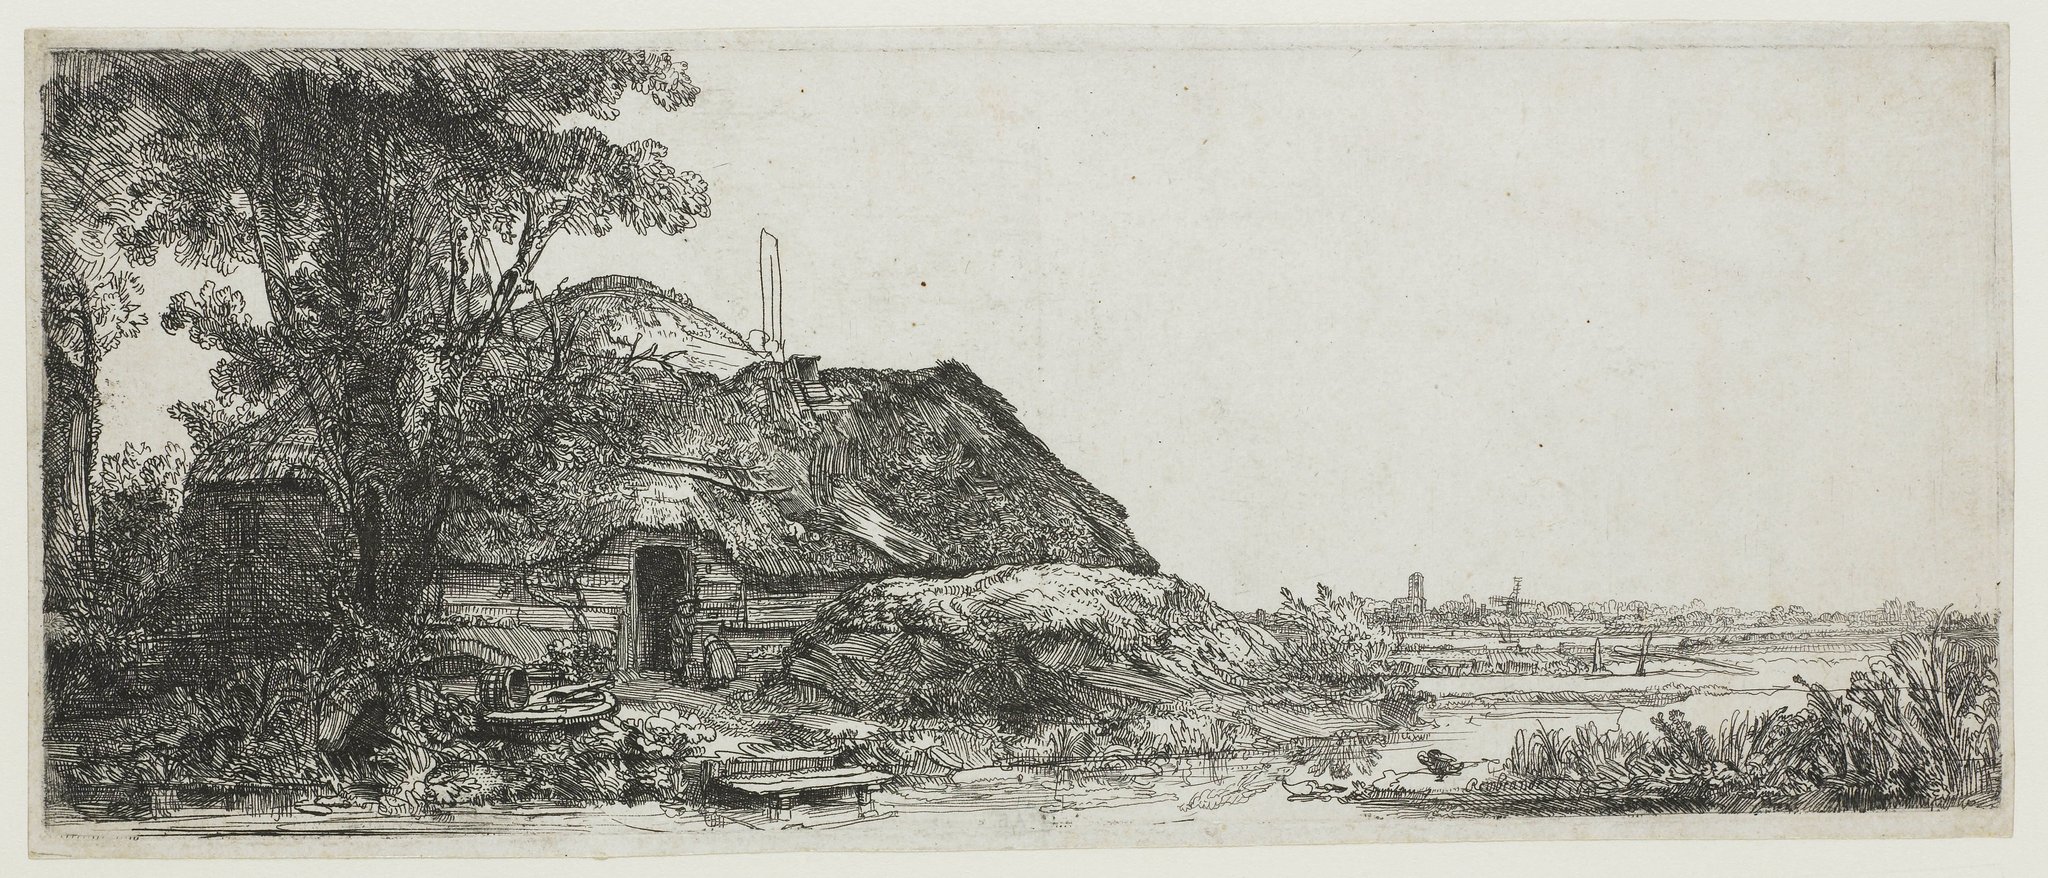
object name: print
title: Landscape with a Cottage and a Large Tree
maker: rembrandt van rijn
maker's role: draughtsman, painter, print maker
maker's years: 1606-1669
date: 1641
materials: paper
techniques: etching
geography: netherlands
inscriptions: mark: Lugt 787, mark: Lugt 2926, signature and date: ‘Rembrandt f 1641’, mark: Lugt 2228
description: The style, subject, oblong format and paper agree so closely with the print displayed above that Rembrandt surely must have meant them as a pair. This type of cottage is called a ‘langhuisboerderij’ (‘longhouse-farmstead’) and has a roof covered with thatch and sod. Rembrandt depicts the dwelling in a dilapidated condition, but still inhabited; two children stand in the doorway.